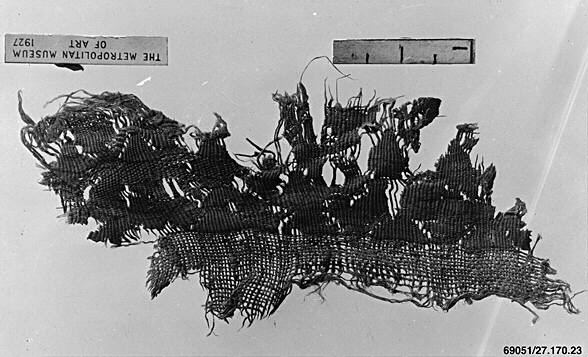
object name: textile fragment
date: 1101-1200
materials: linen, silk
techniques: tapestry, weave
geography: egypt